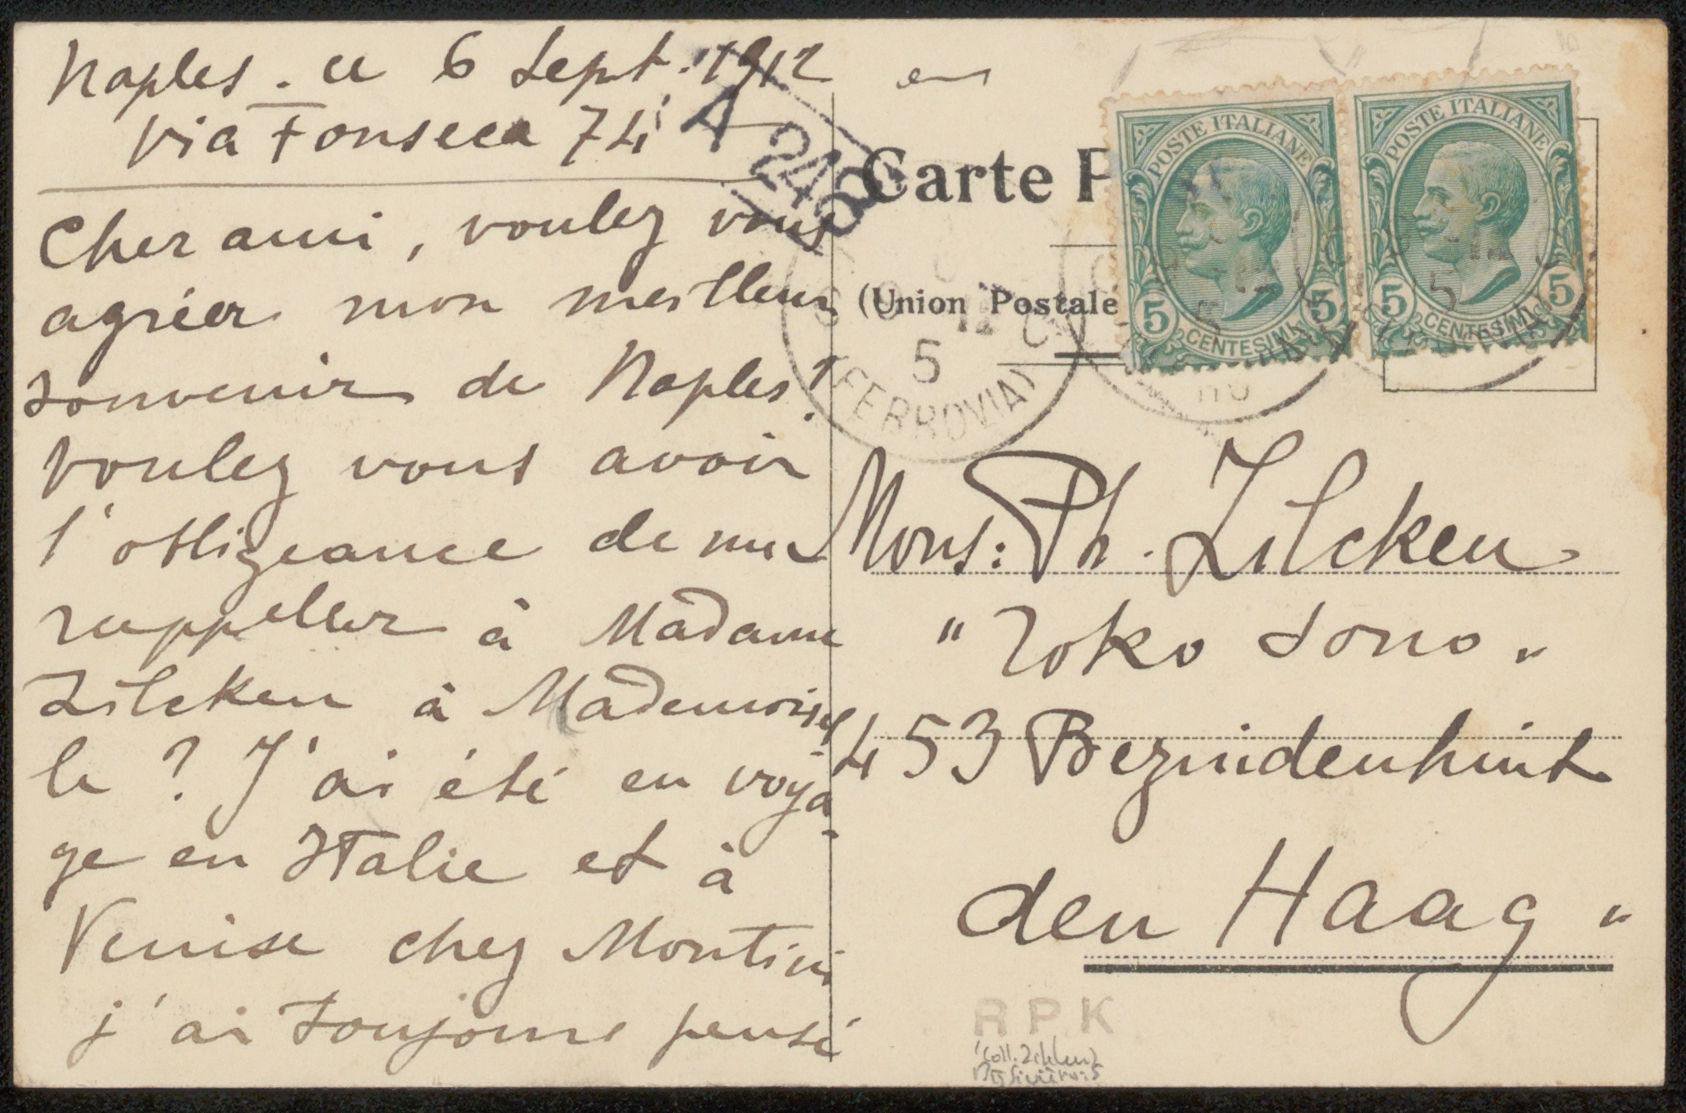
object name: ansichtkaart, prentbriefkaart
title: Prentbriefkaart aan Philip Zilcken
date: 1912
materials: cardboard, ink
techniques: photograph, pen, writing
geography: naples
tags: naples, vittorio pica, the hague, philip zilcken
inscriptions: collector's mark: ‘RPK’